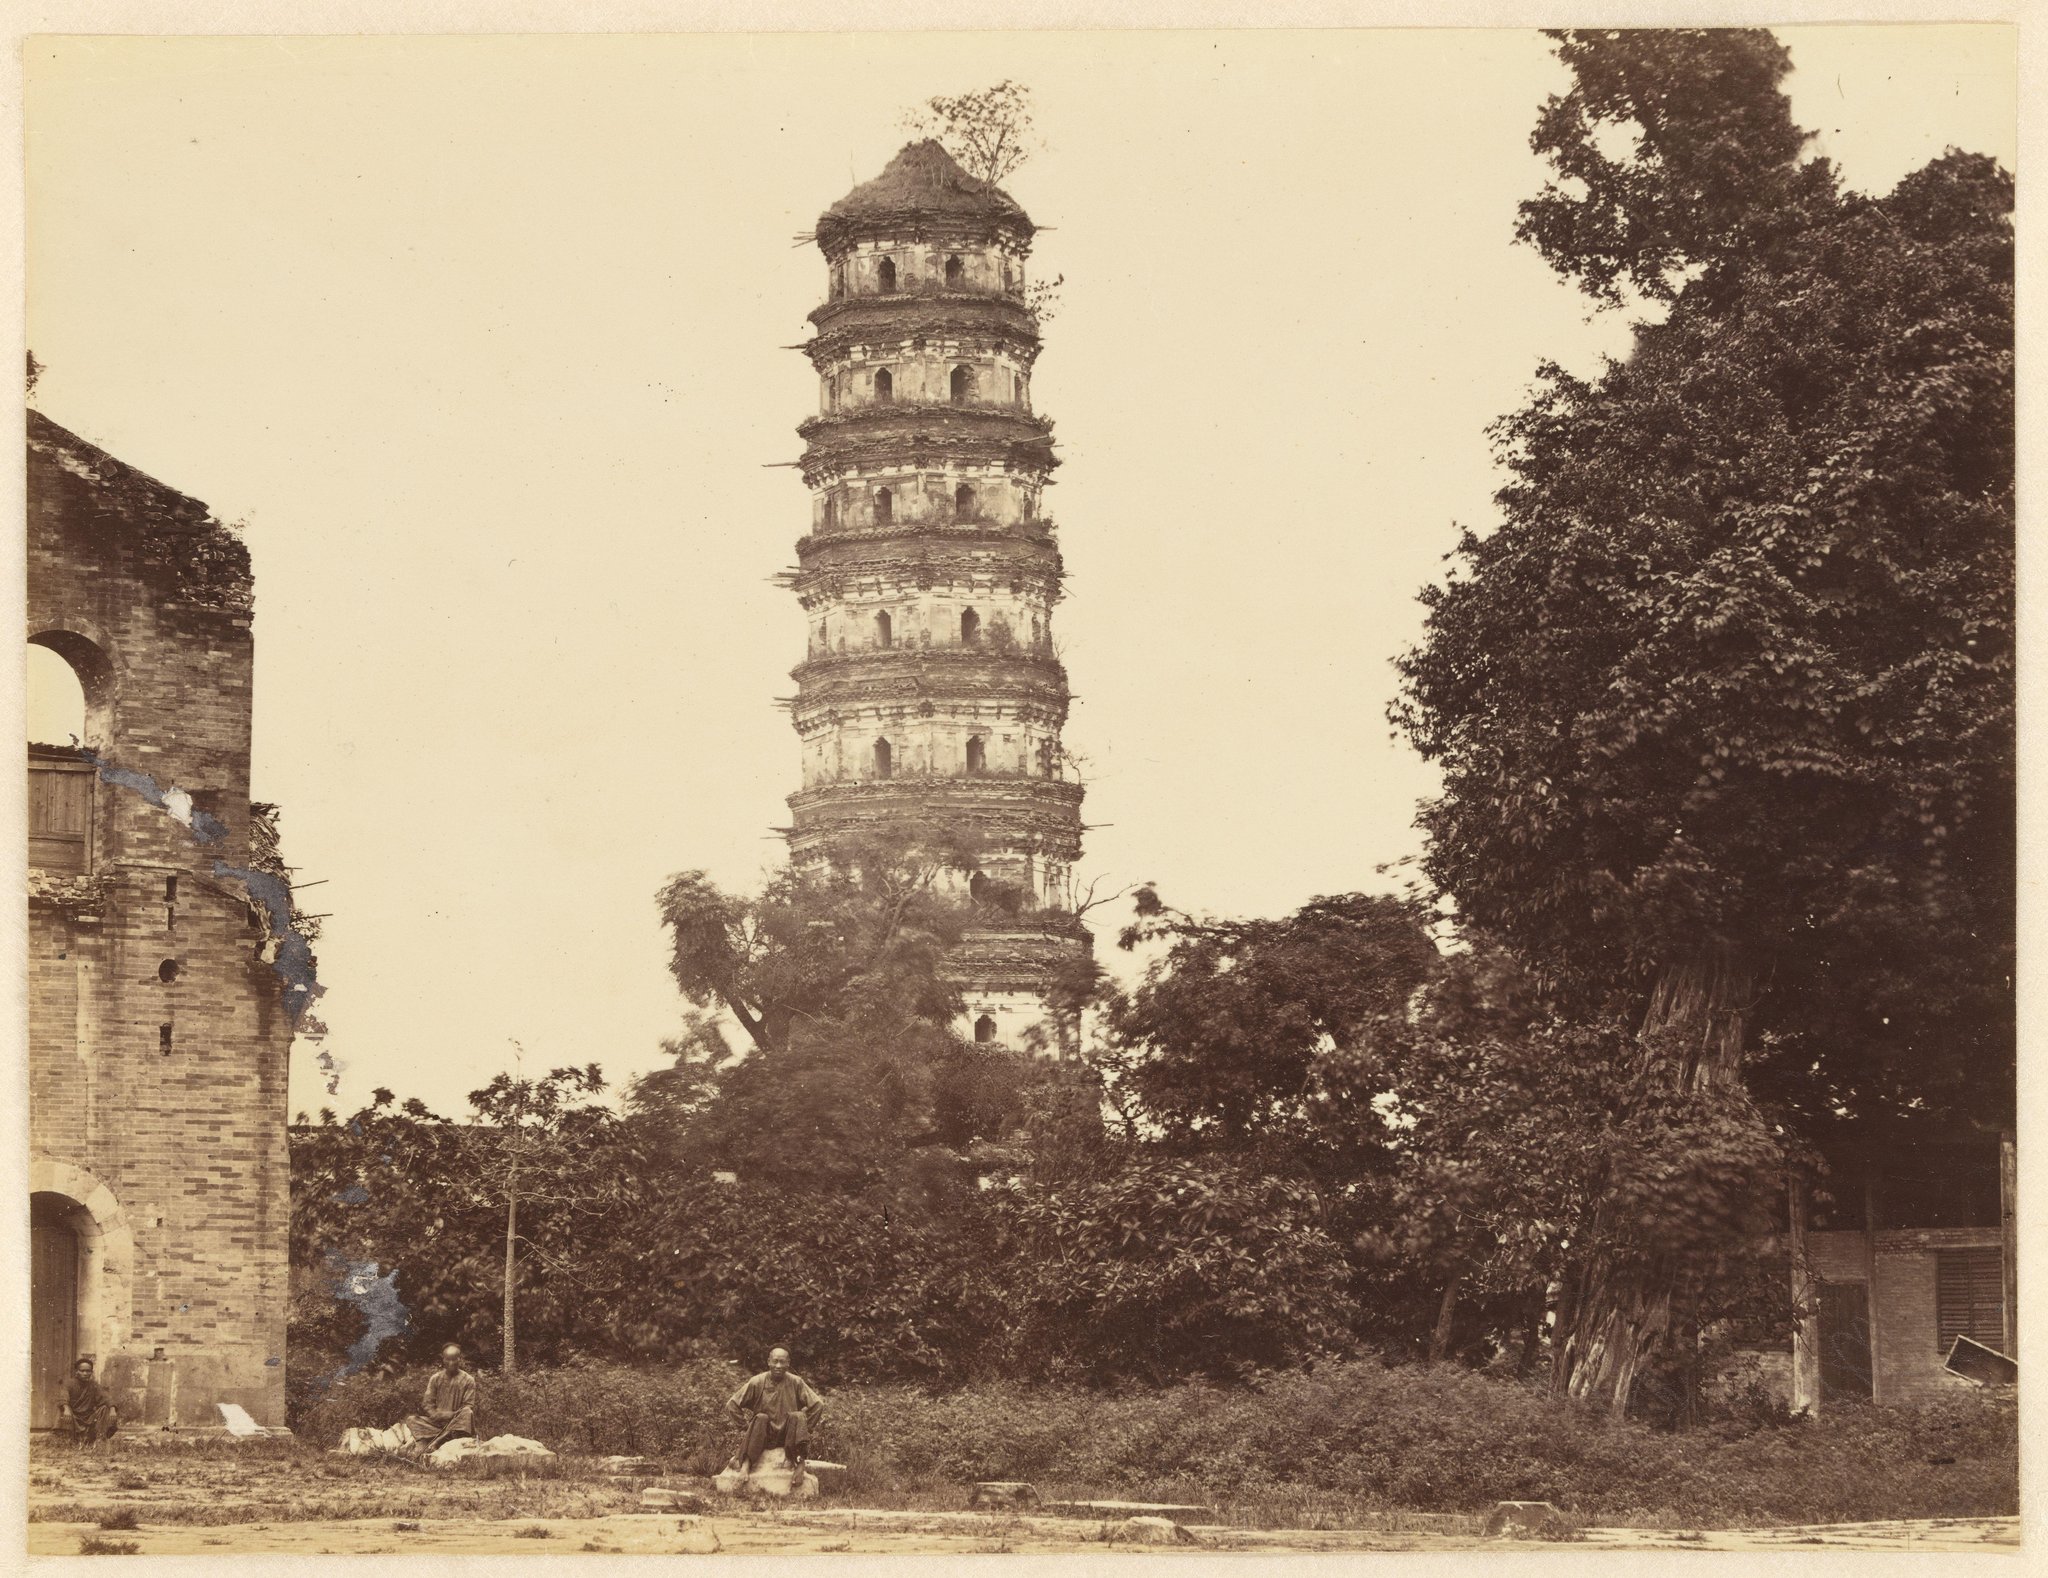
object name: photograph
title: Pagode in Canton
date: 1863-1870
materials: paper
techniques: albumen print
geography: china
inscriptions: inscription: ‘... Pagode ...’, number: ‘13’, number: ‘183’